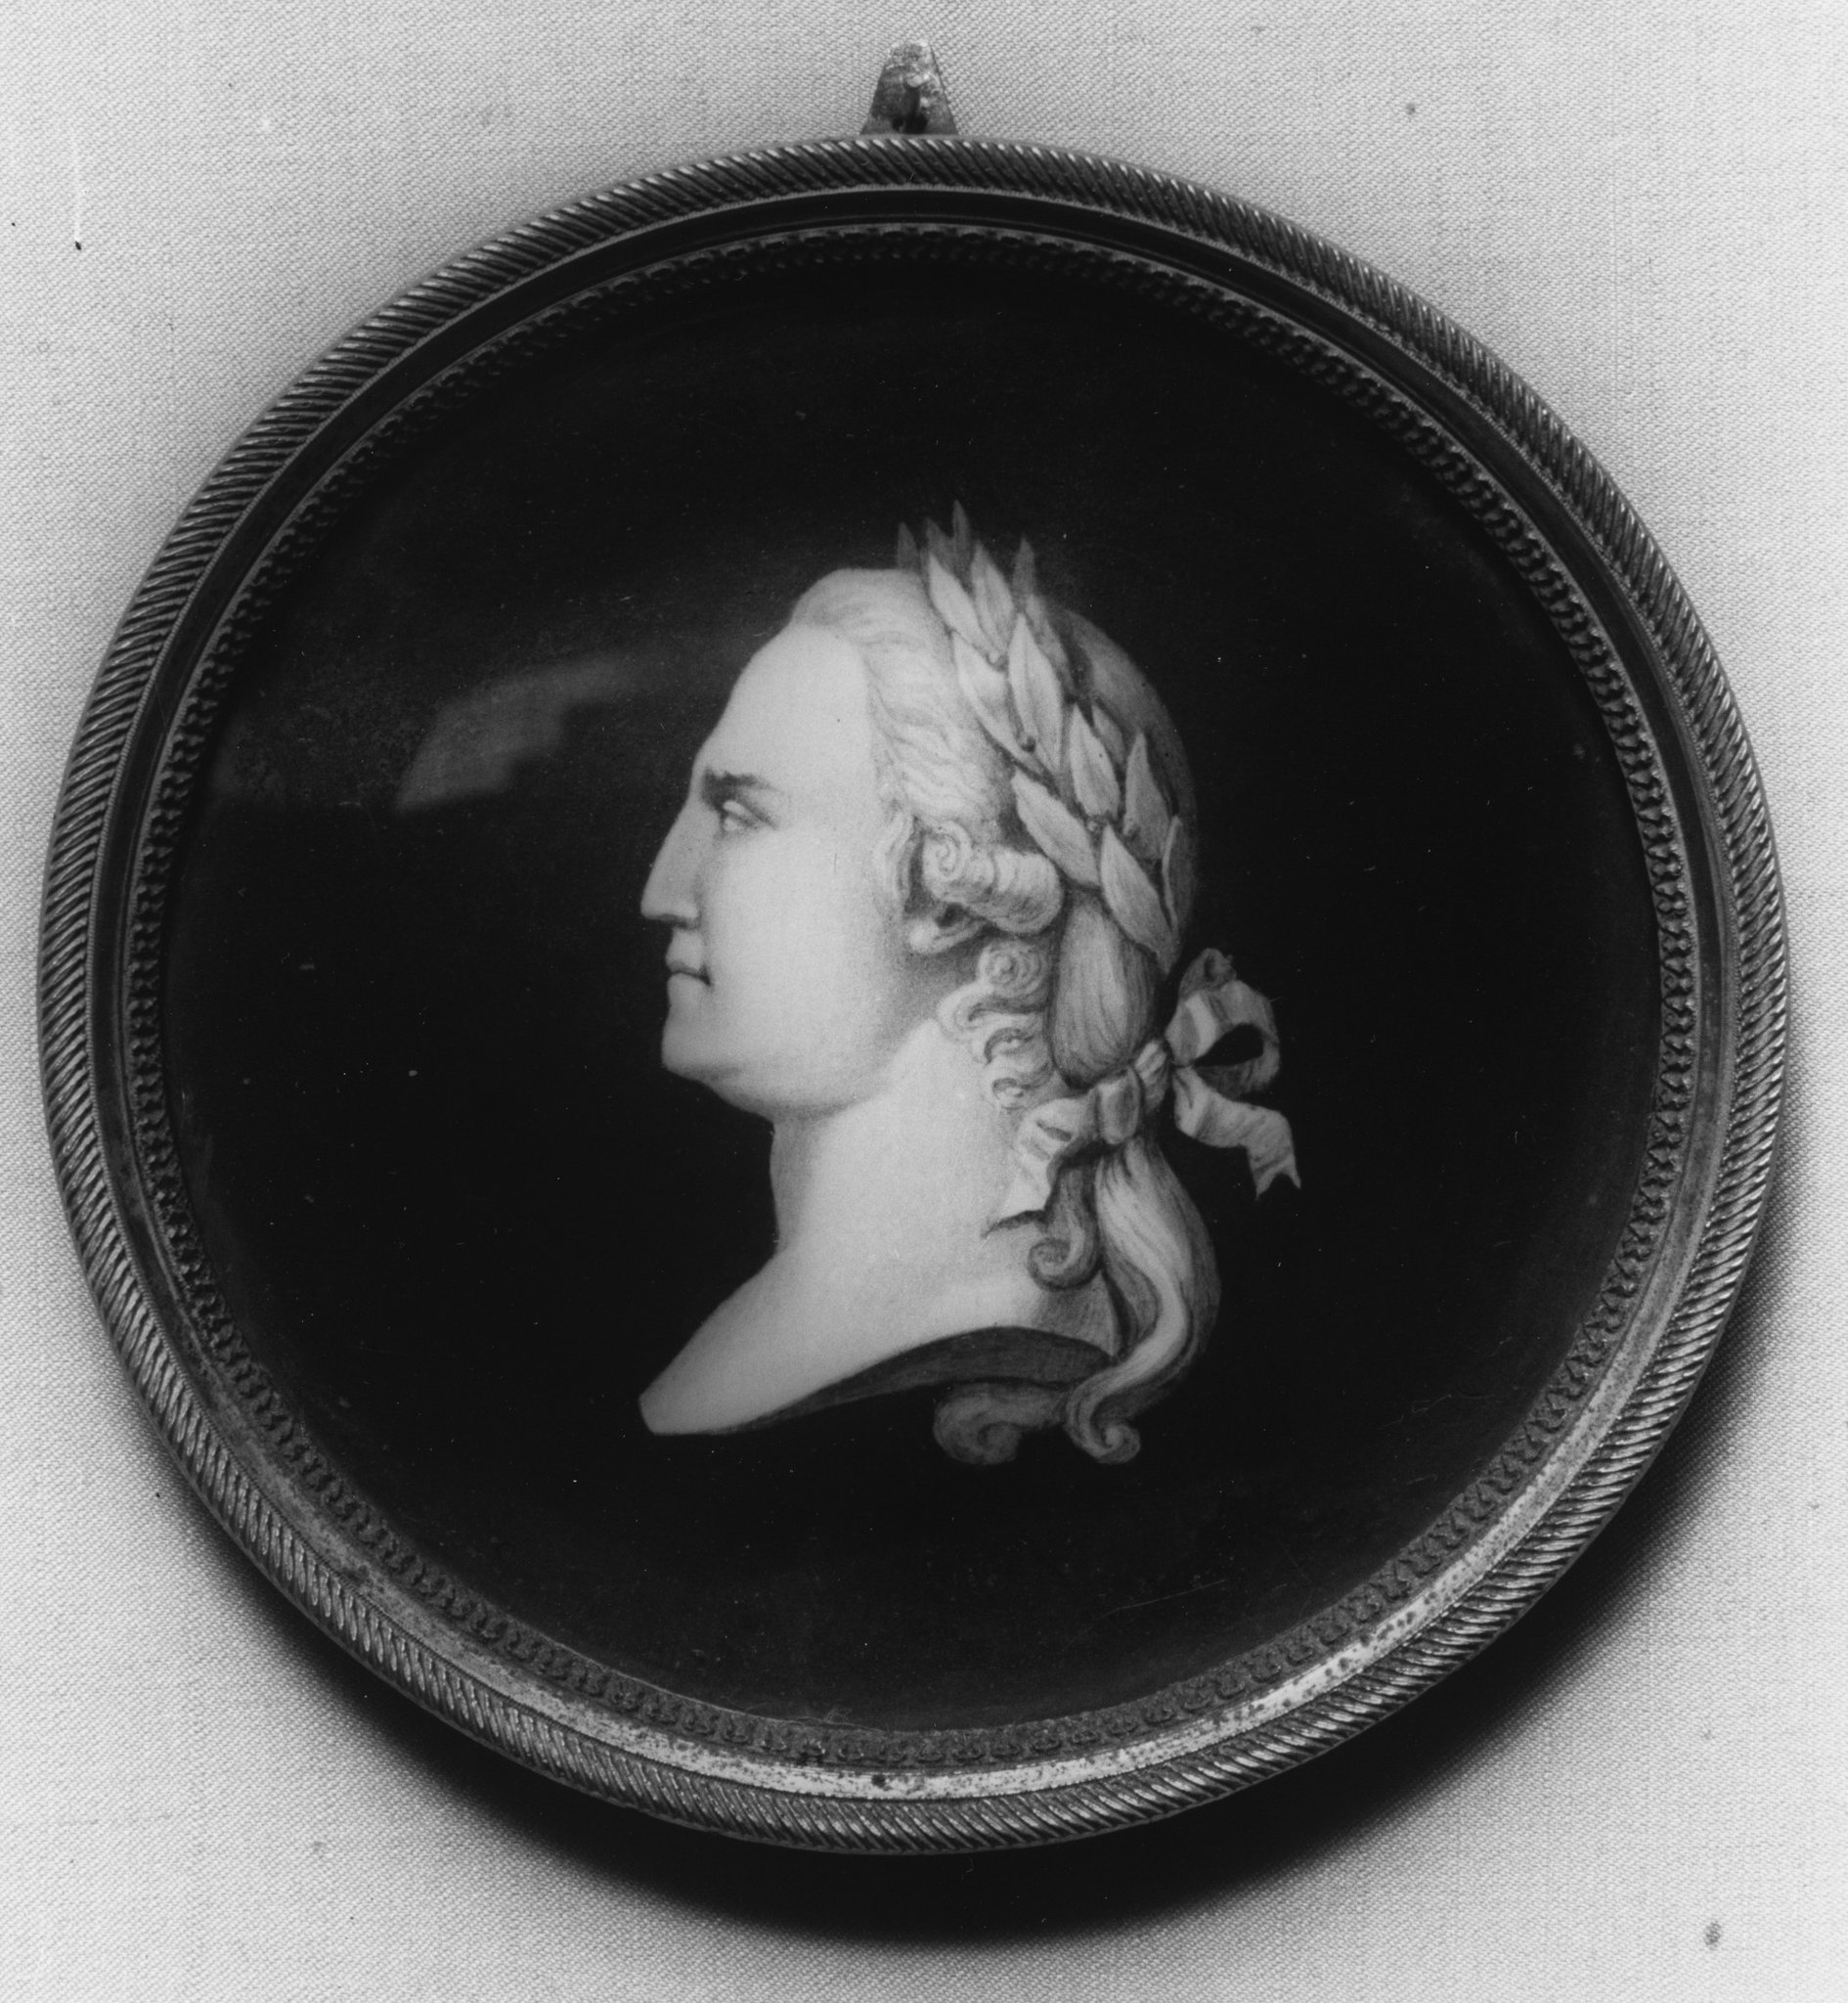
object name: plaque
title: George Washington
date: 1805-1810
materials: ivory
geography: france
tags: george washington,men,profiles